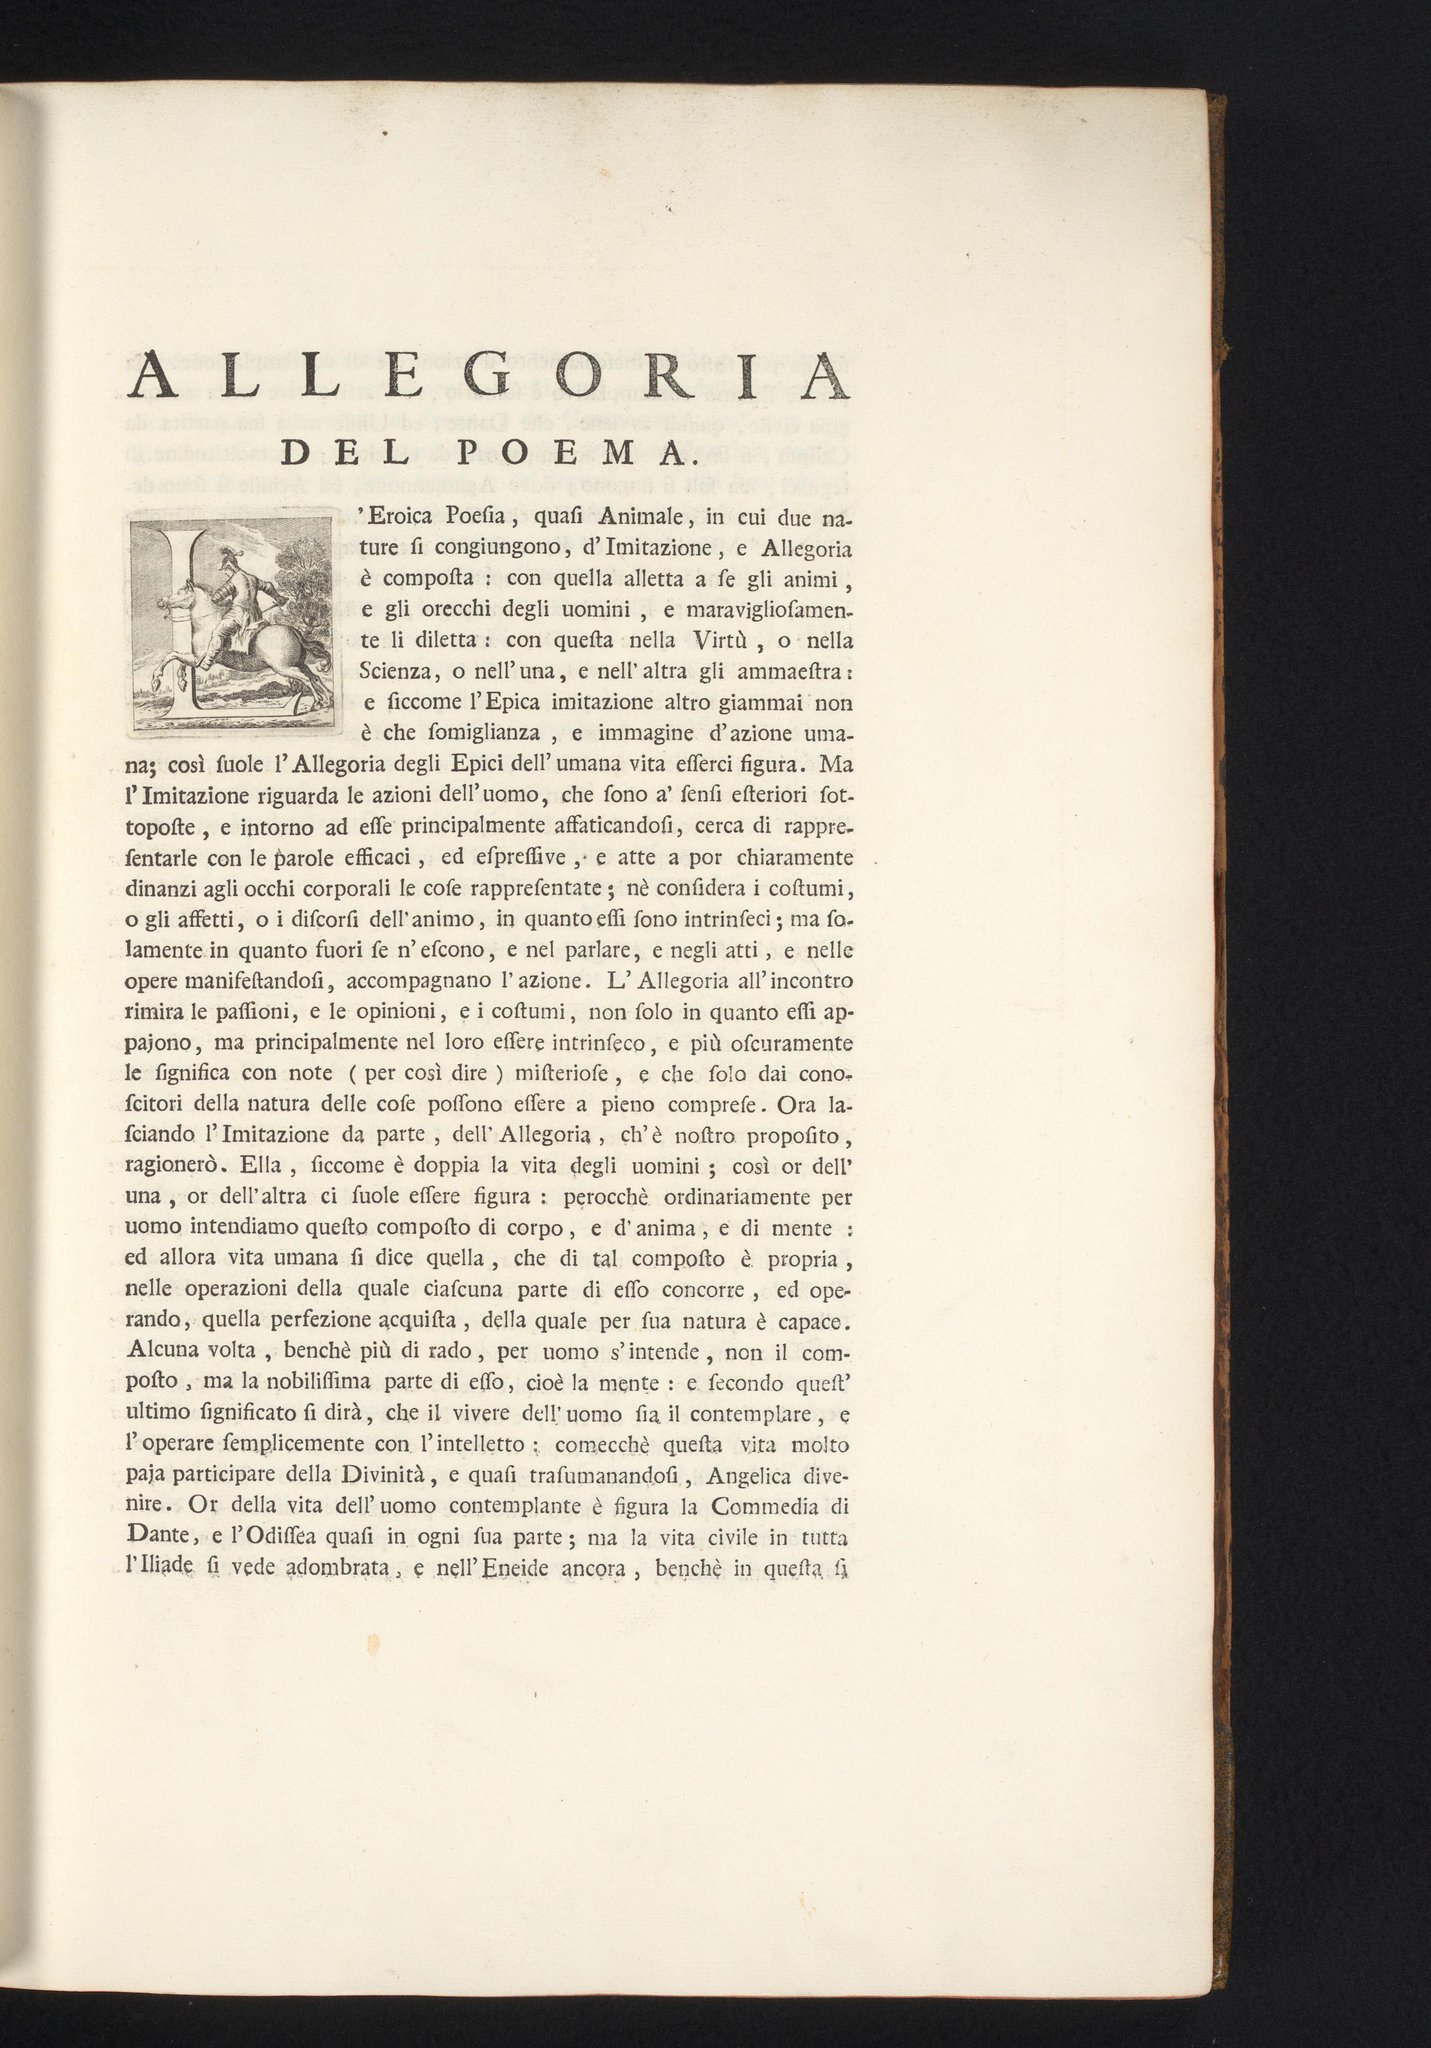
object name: page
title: Initiaal L met cavalerist te paard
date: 1745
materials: paper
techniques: etching, letterpress printing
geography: venice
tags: private soldier (+ cavalry, horsemen), initial, (scenes from) specific works of literature: tasso, gerusalemme liberata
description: Prent uit: Tasso, Torquato. La Gerusalemme liberata di Torquato Tasso con le figure de Giambatista Piazzetta. Venetië: Giambatista Albrizzi, 1745.